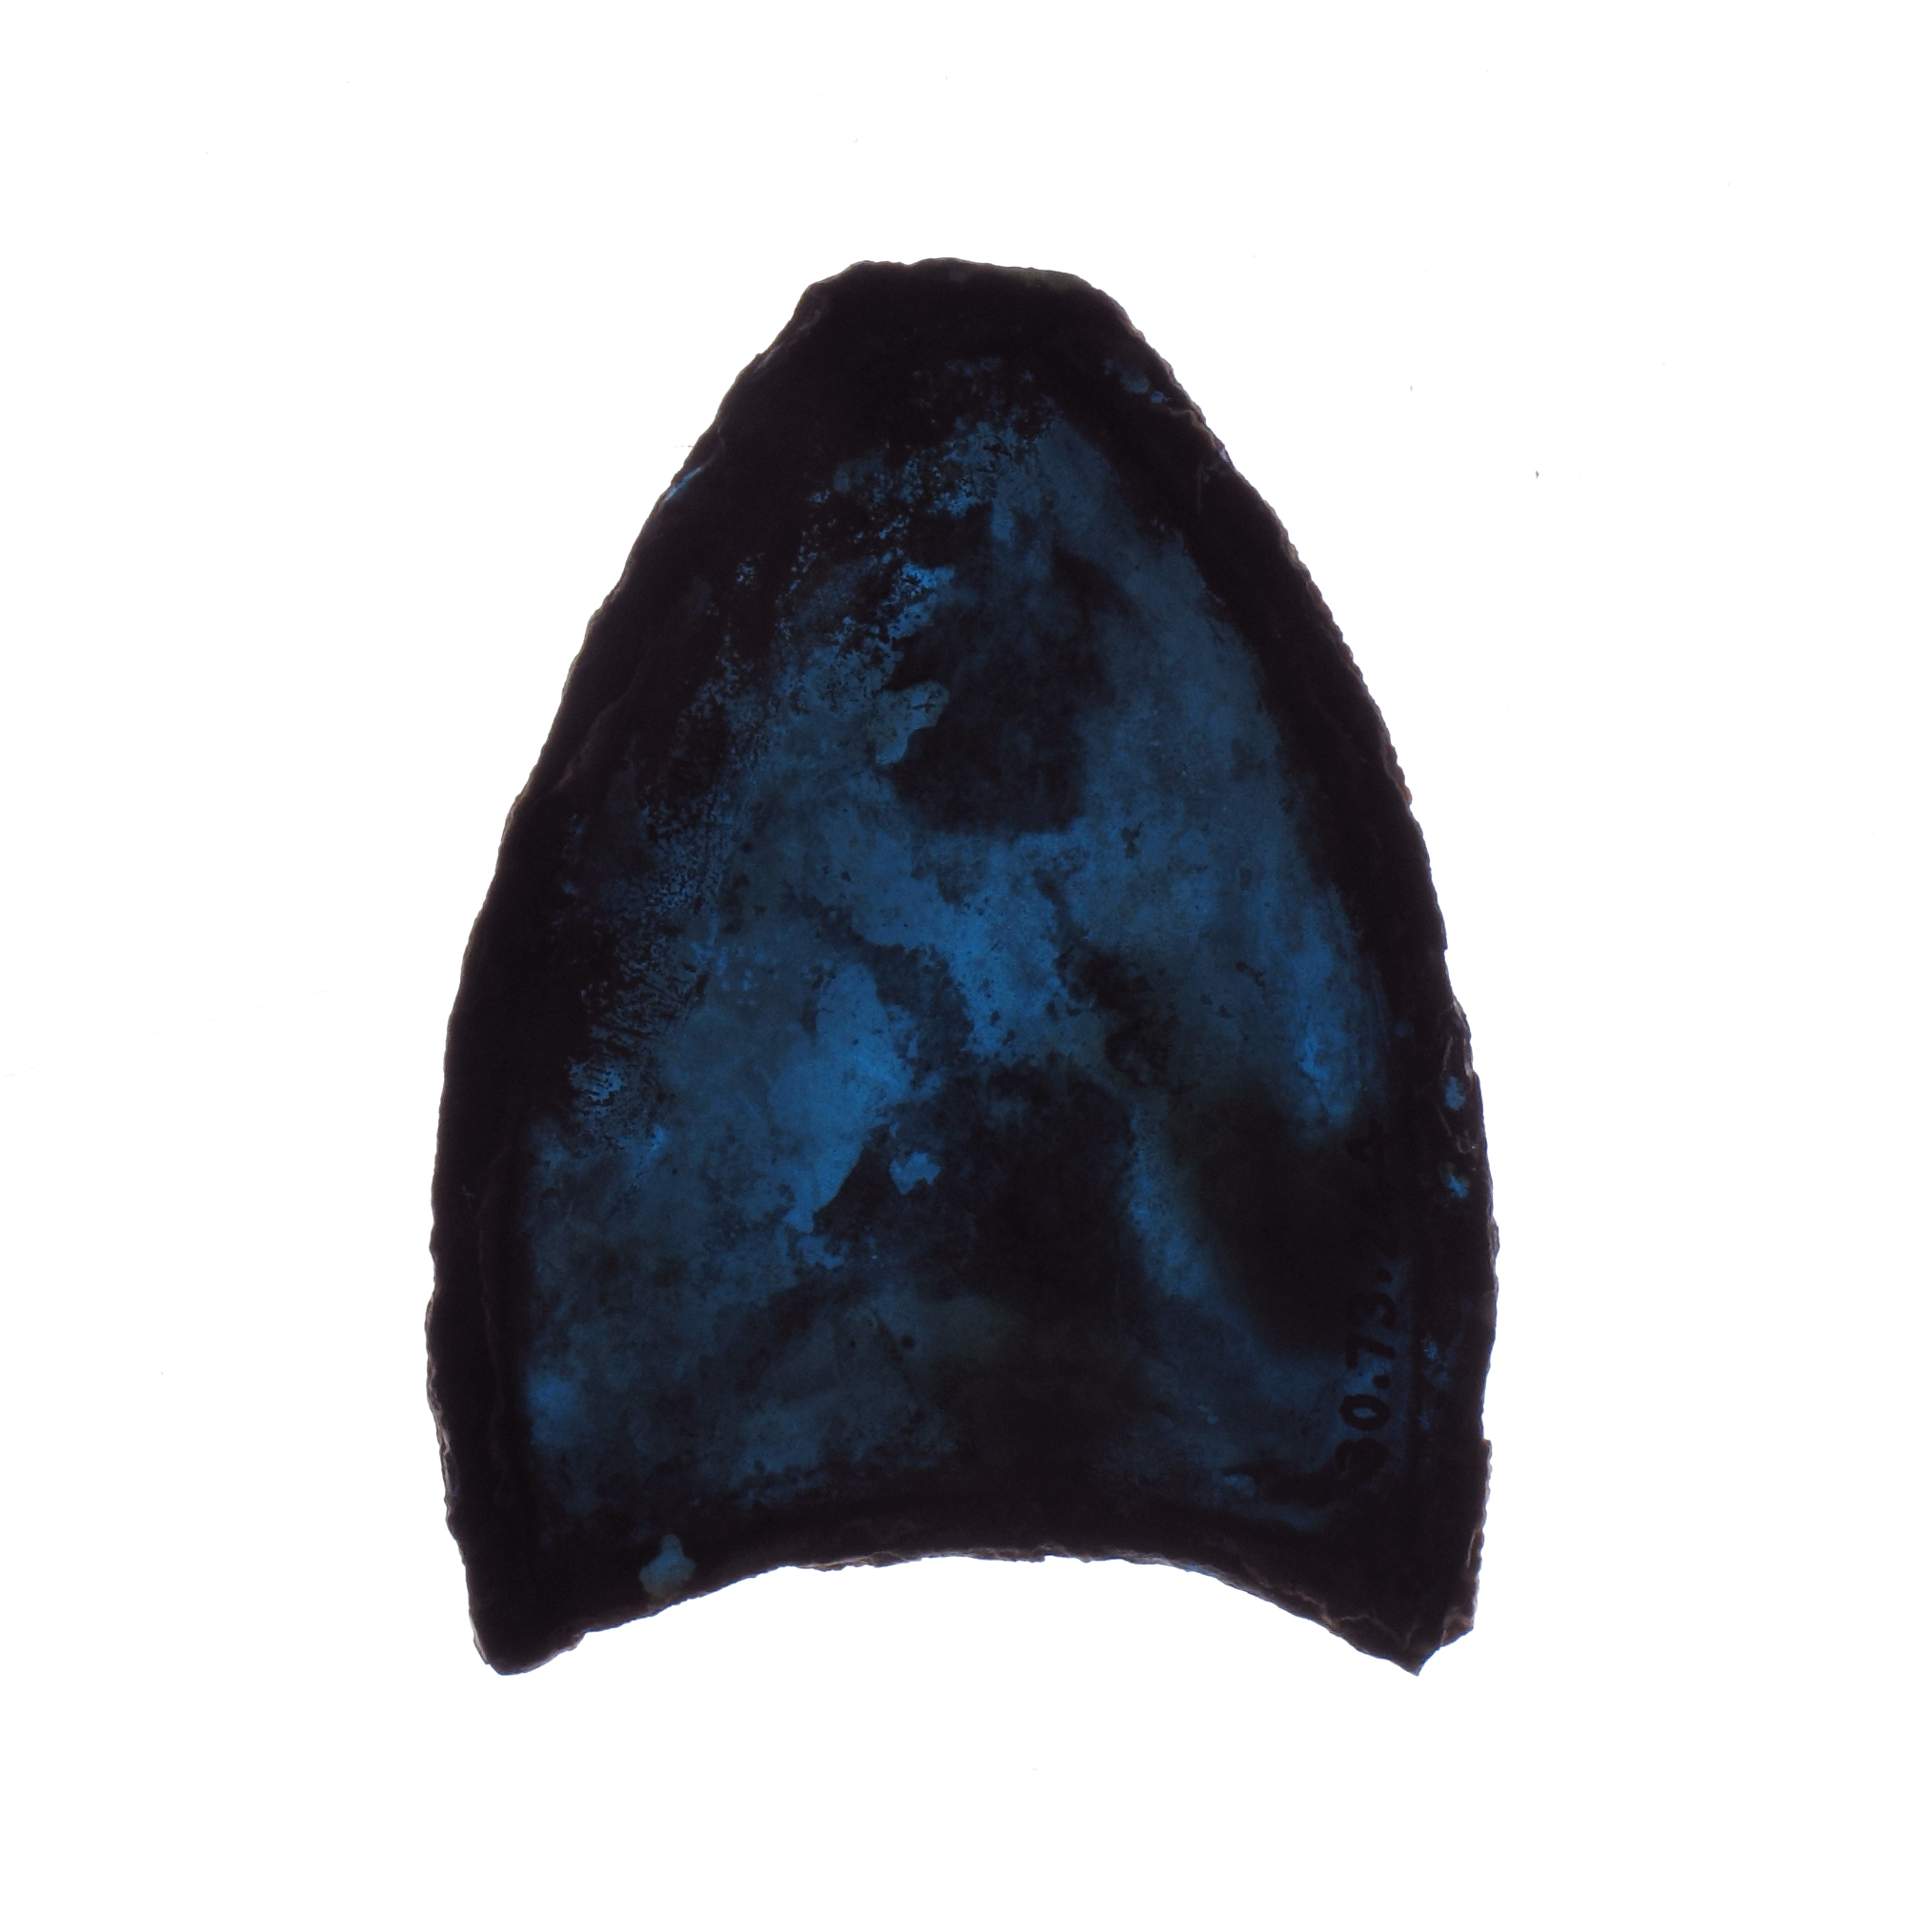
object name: fragment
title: Glass Fragment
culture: european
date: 1201-1400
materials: glass, metal